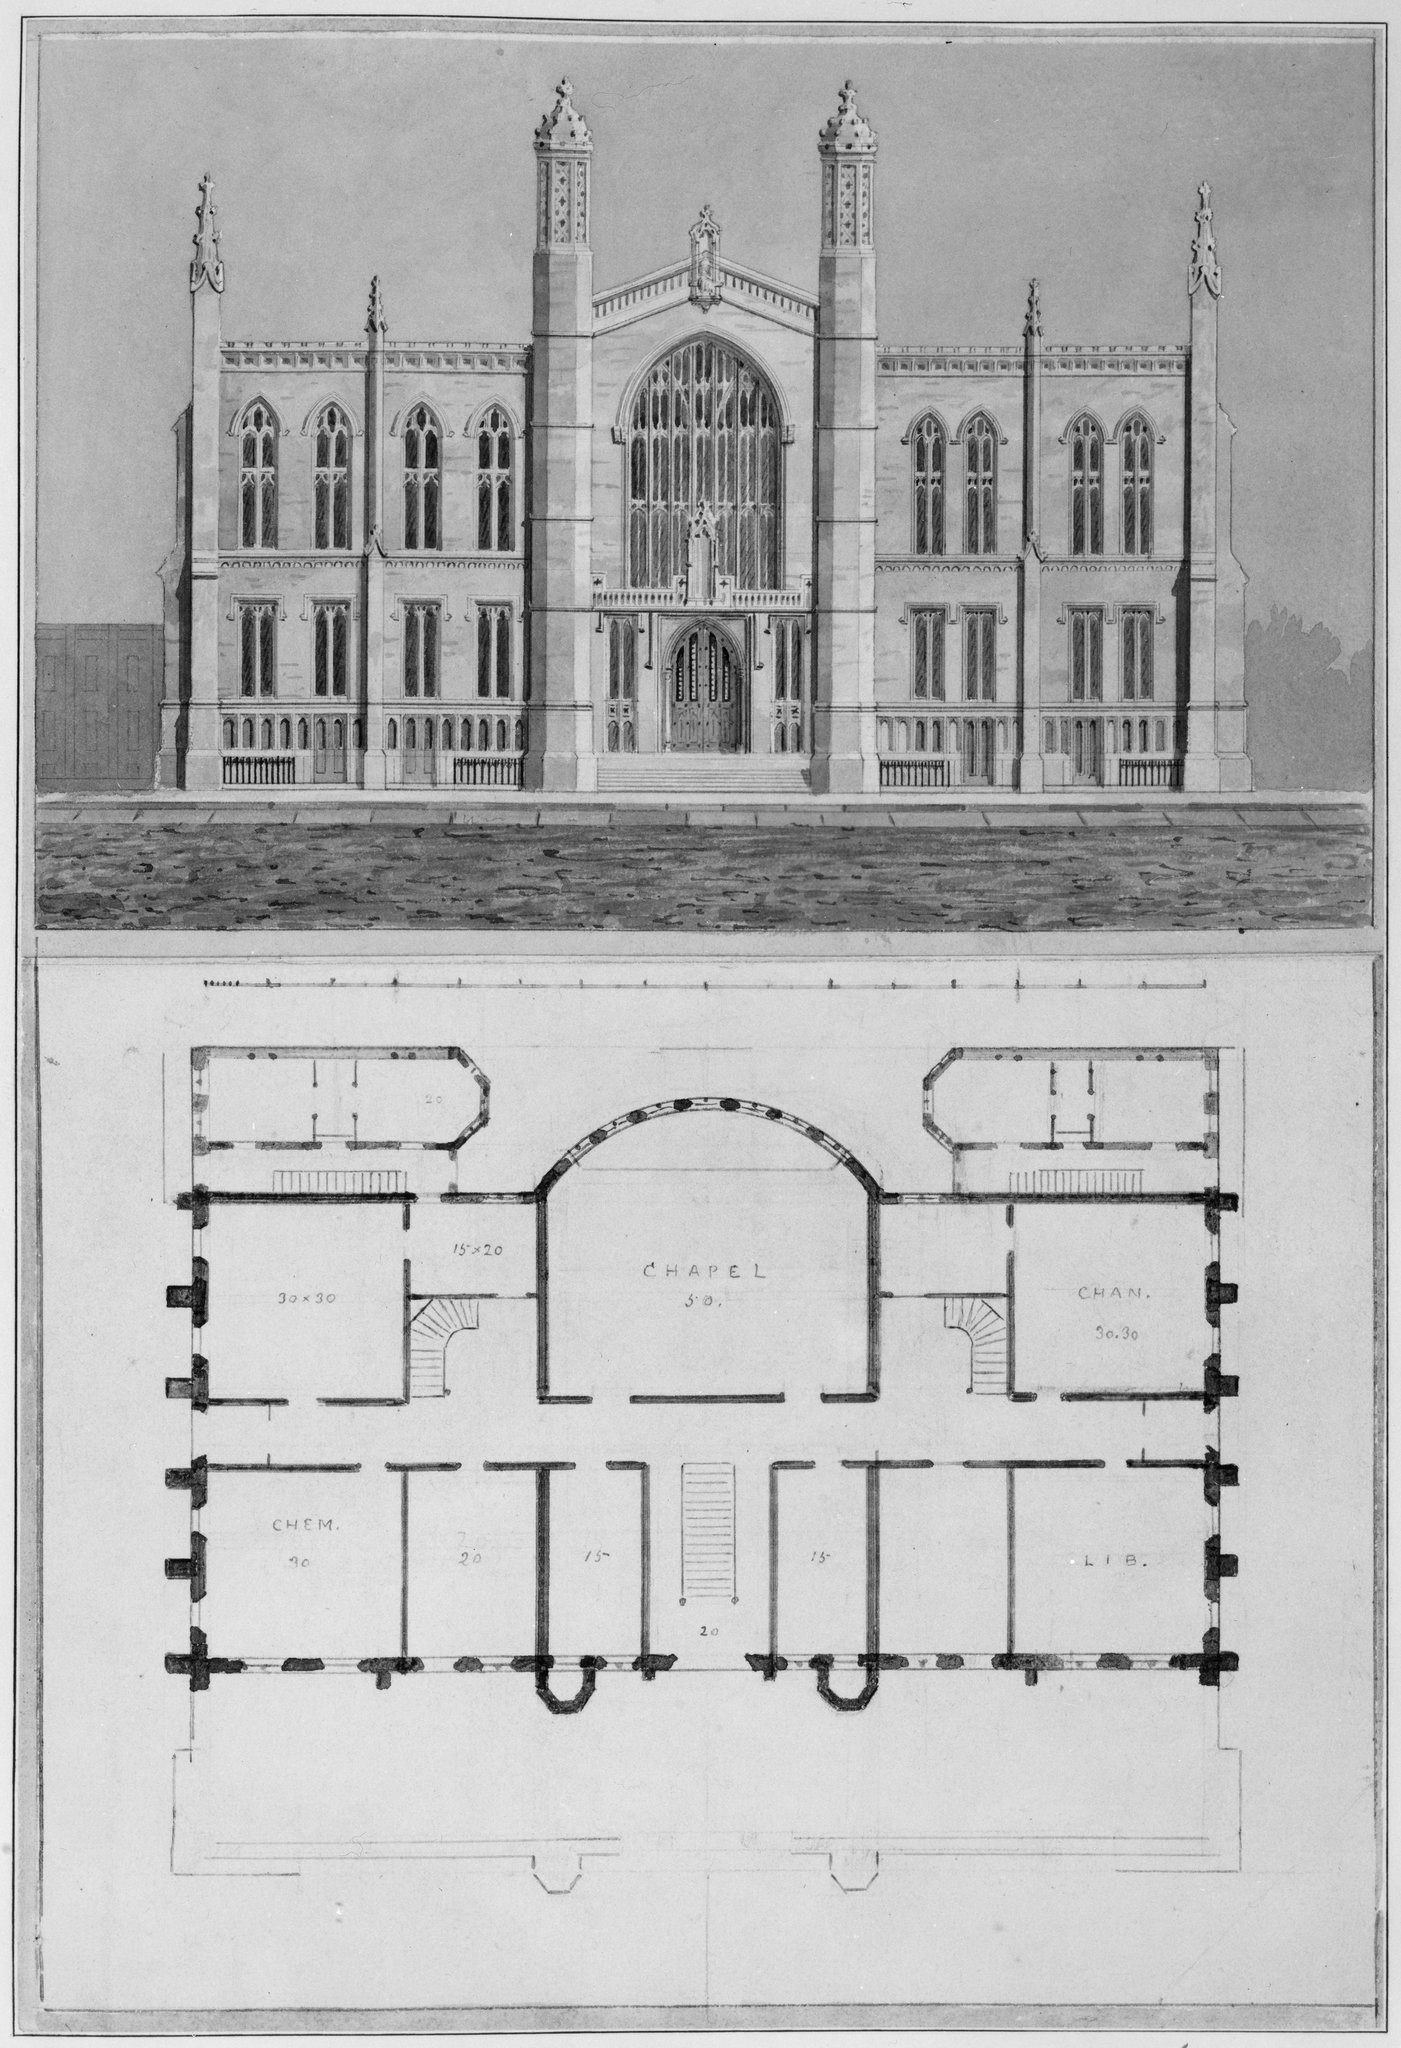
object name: album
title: New York University College of Physicians and Surgeons, Buildings and Other Material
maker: alexander jackson davis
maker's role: artist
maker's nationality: american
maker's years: 1803-1892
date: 1801-1900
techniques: drawing